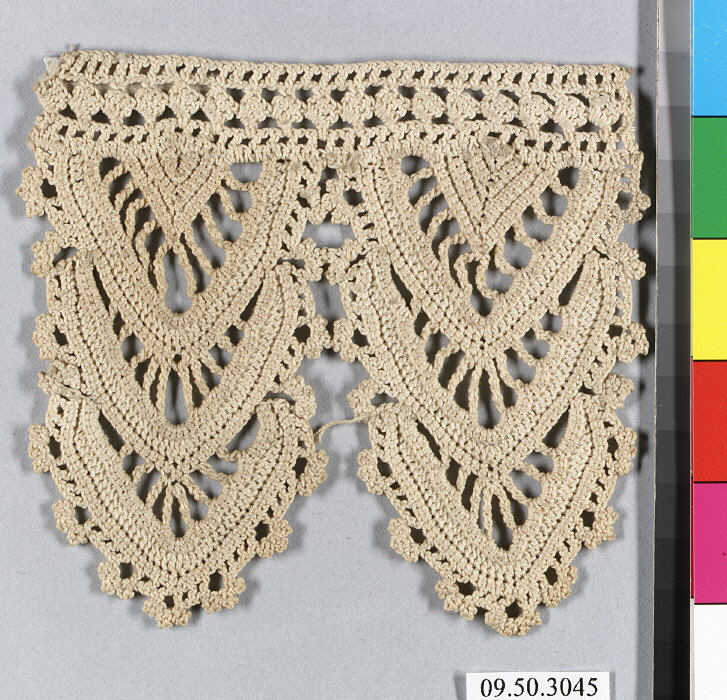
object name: sample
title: Crochet Work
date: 1801-1900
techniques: crochet